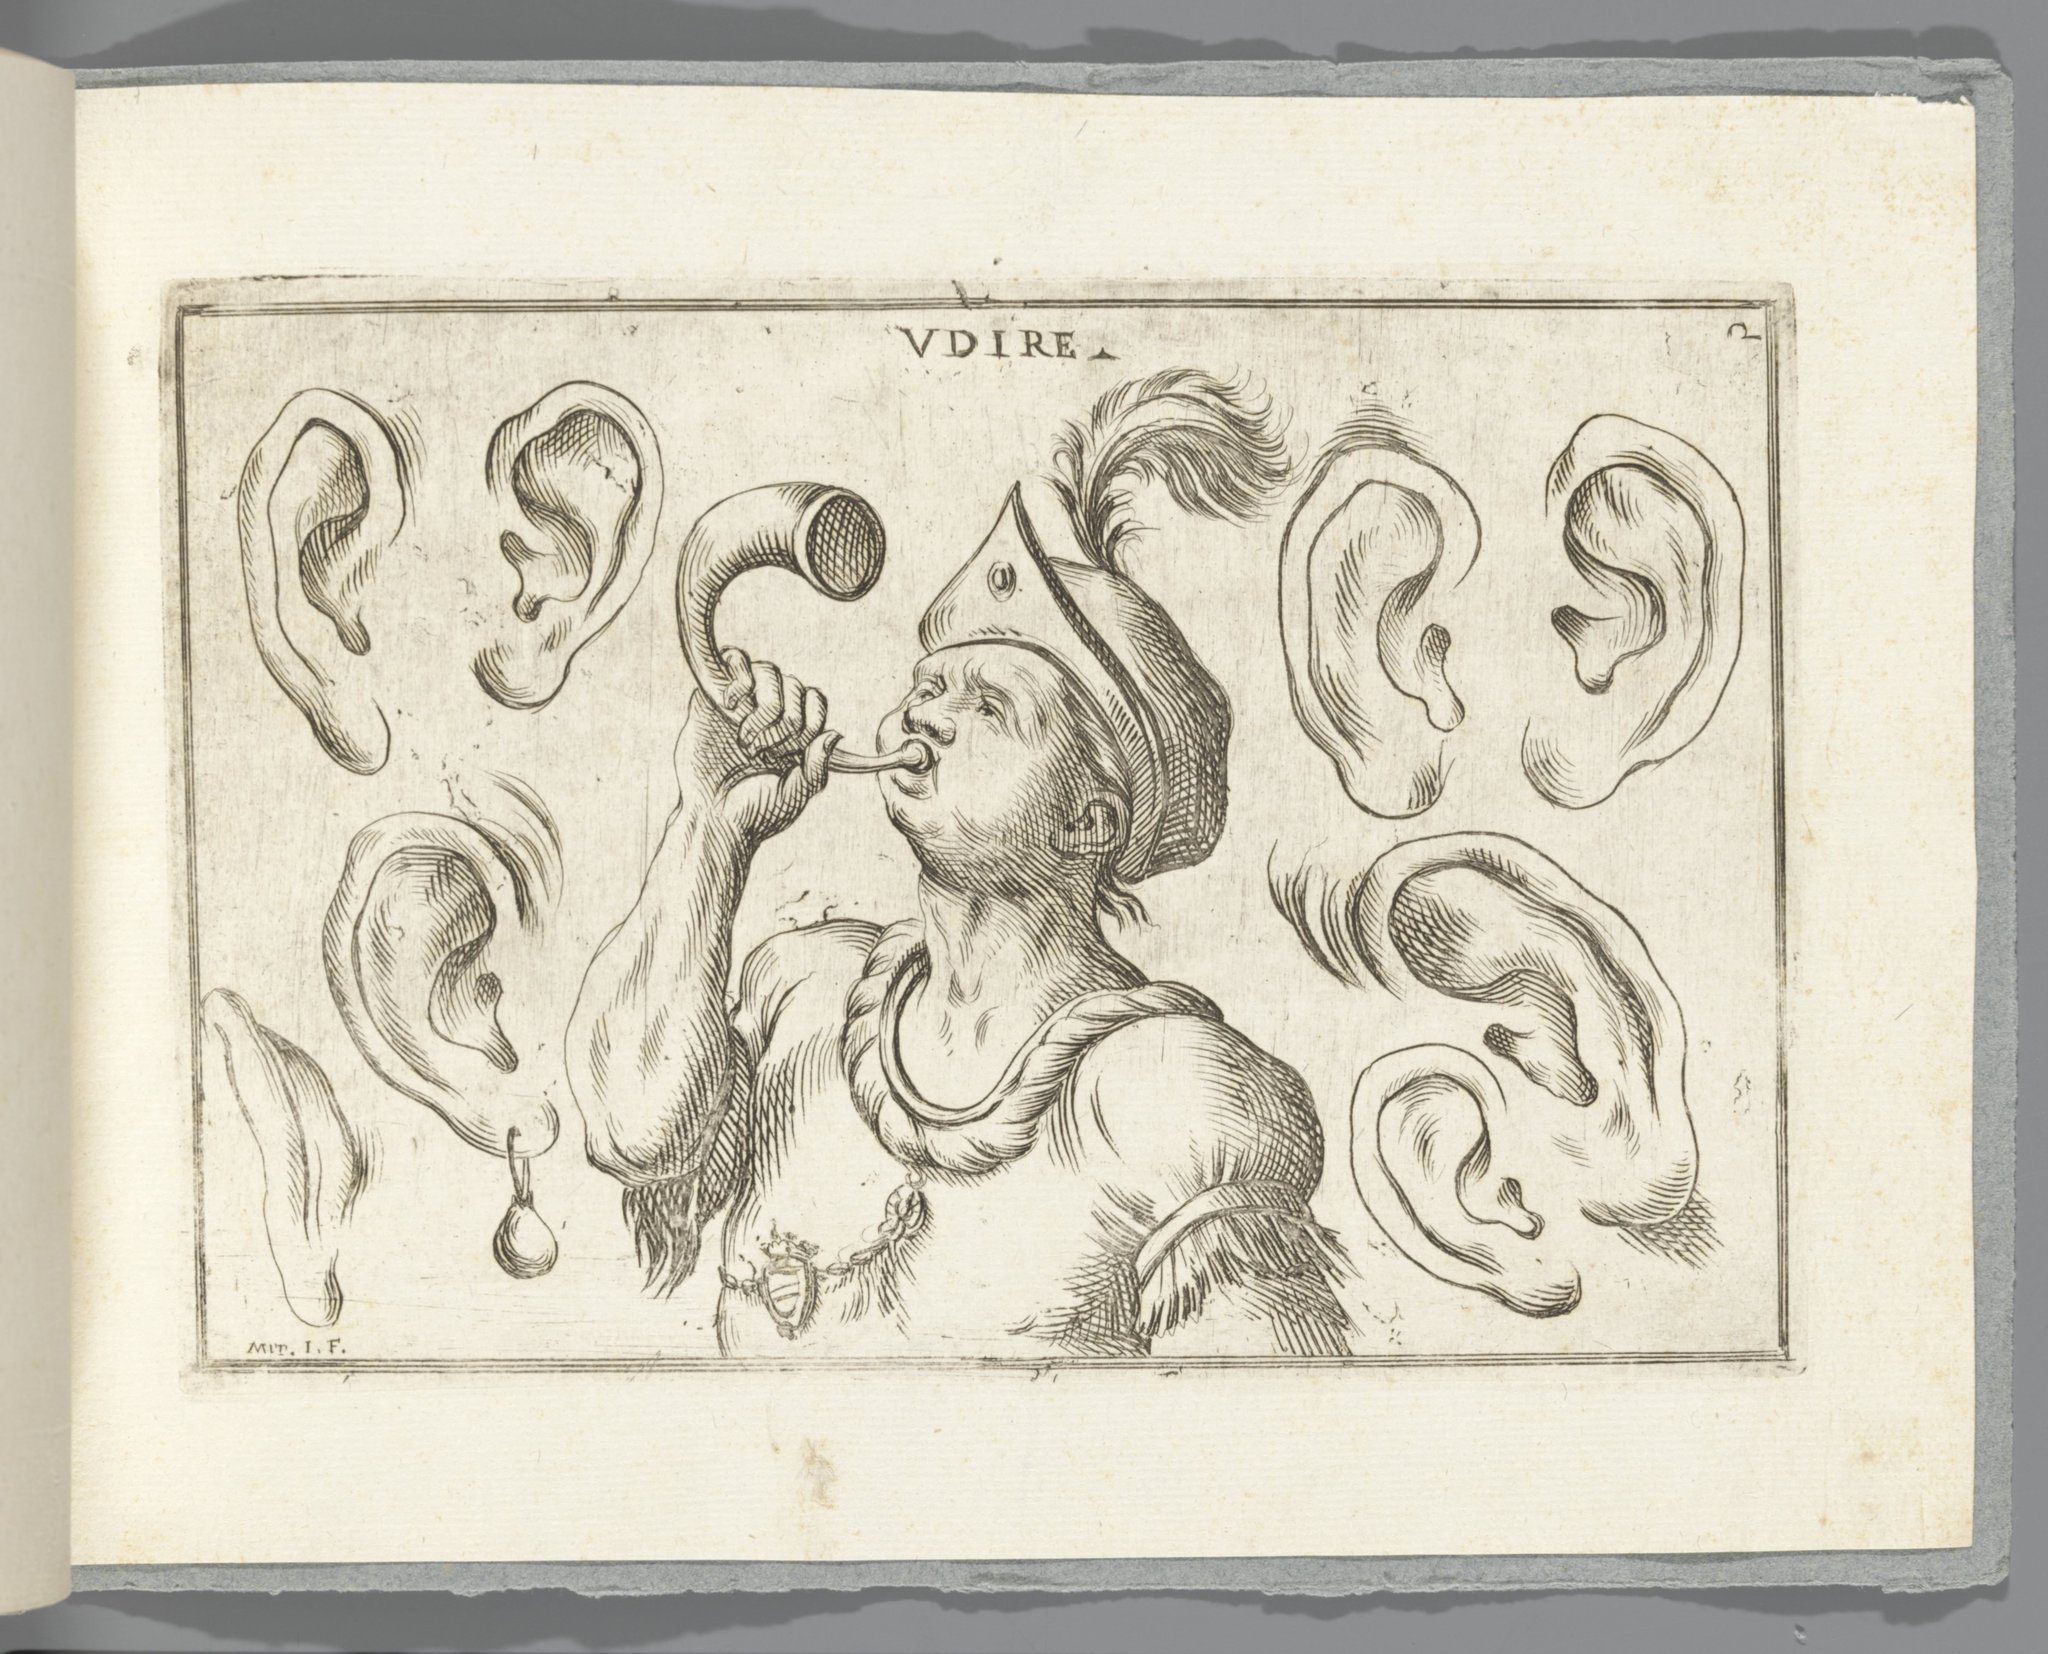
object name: print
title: Gehoor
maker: giuseppe maria mitelli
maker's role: draughtsman, painter, print maker, publisher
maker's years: 1634-1718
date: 1700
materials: paper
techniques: etching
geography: italy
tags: hearing, listening (one of the five senses)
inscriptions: collector's mark: Lugt 2228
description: Prent uit tekenboekje opgebouwd rond de vijf zintuigen. Essemplare Per Disegnare Di Rame, nr. 12. Essemplare Per Disegnare Di Rame, nr. 12. Vijf prenten met tekenvoorbeelden opgebouwd rond personificaties van de vijf zintuigen gebonden in een 18de(?)-eeuws omslag van blauwgrijs papier.